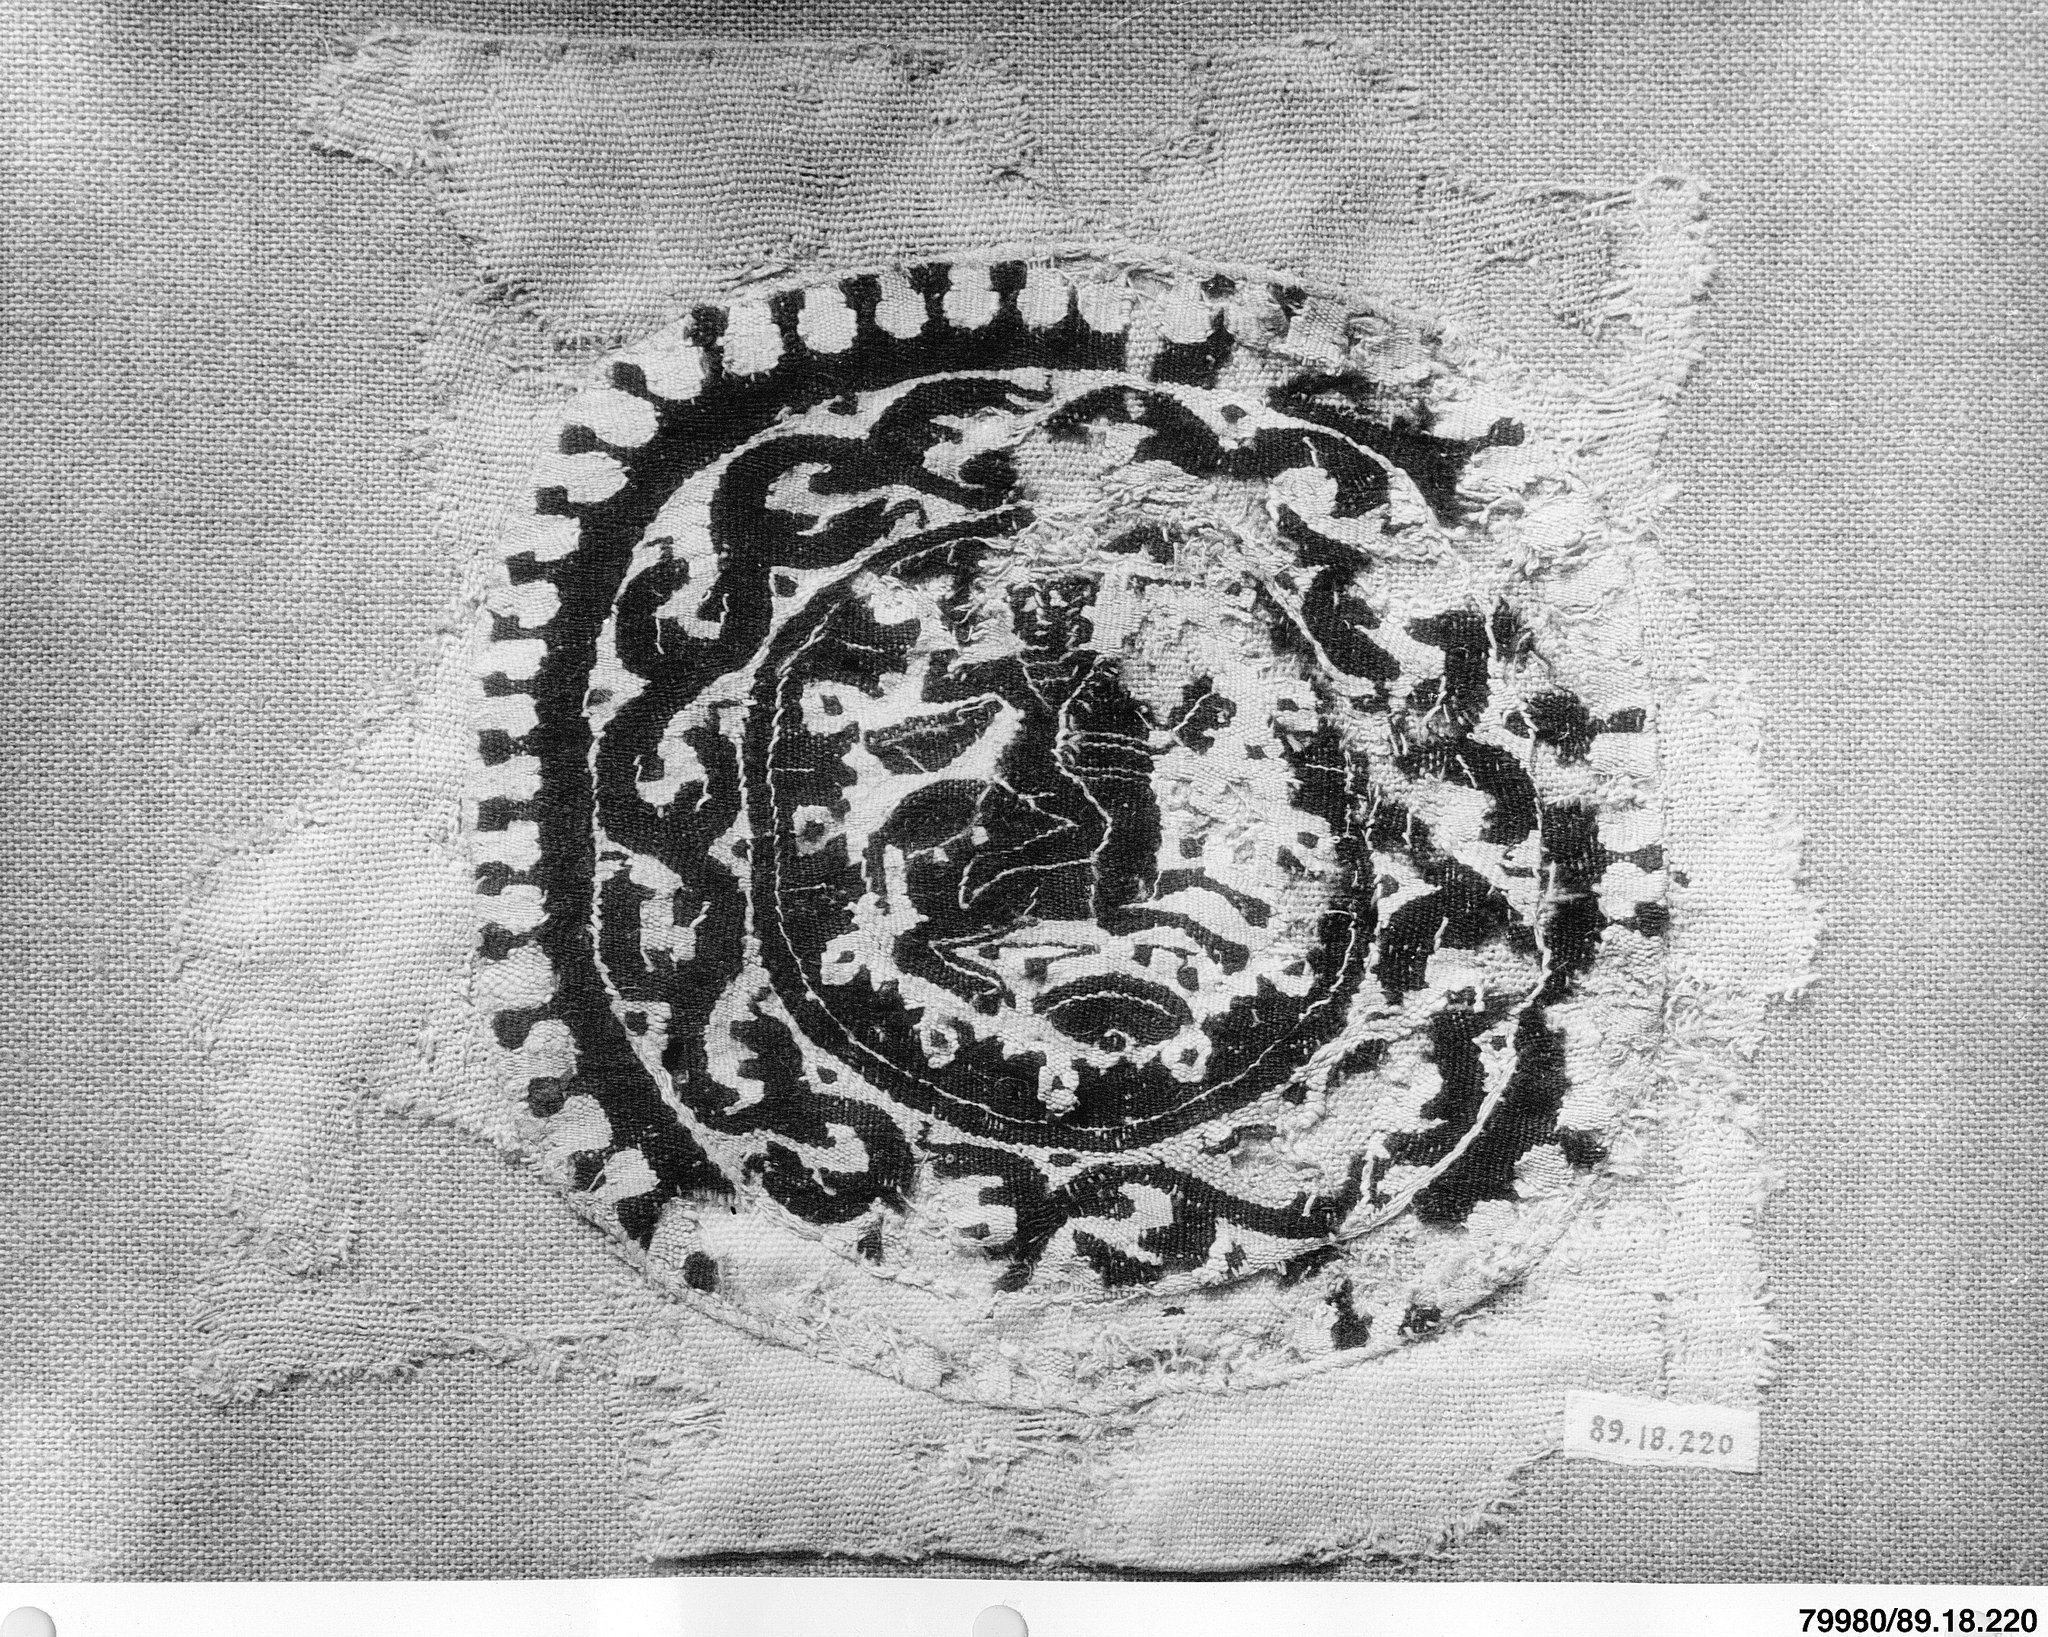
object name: textile fragment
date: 301-400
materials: linen, wool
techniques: weave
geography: egypt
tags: horses